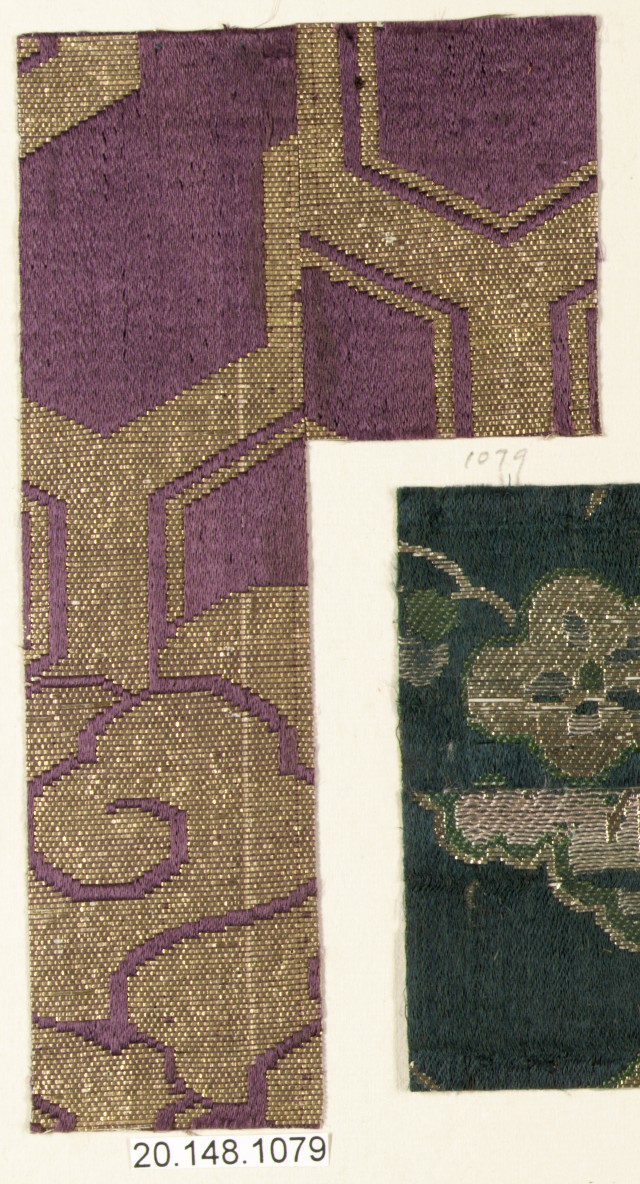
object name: piece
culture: japanese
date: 1801-1900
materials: silk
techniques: compound weave